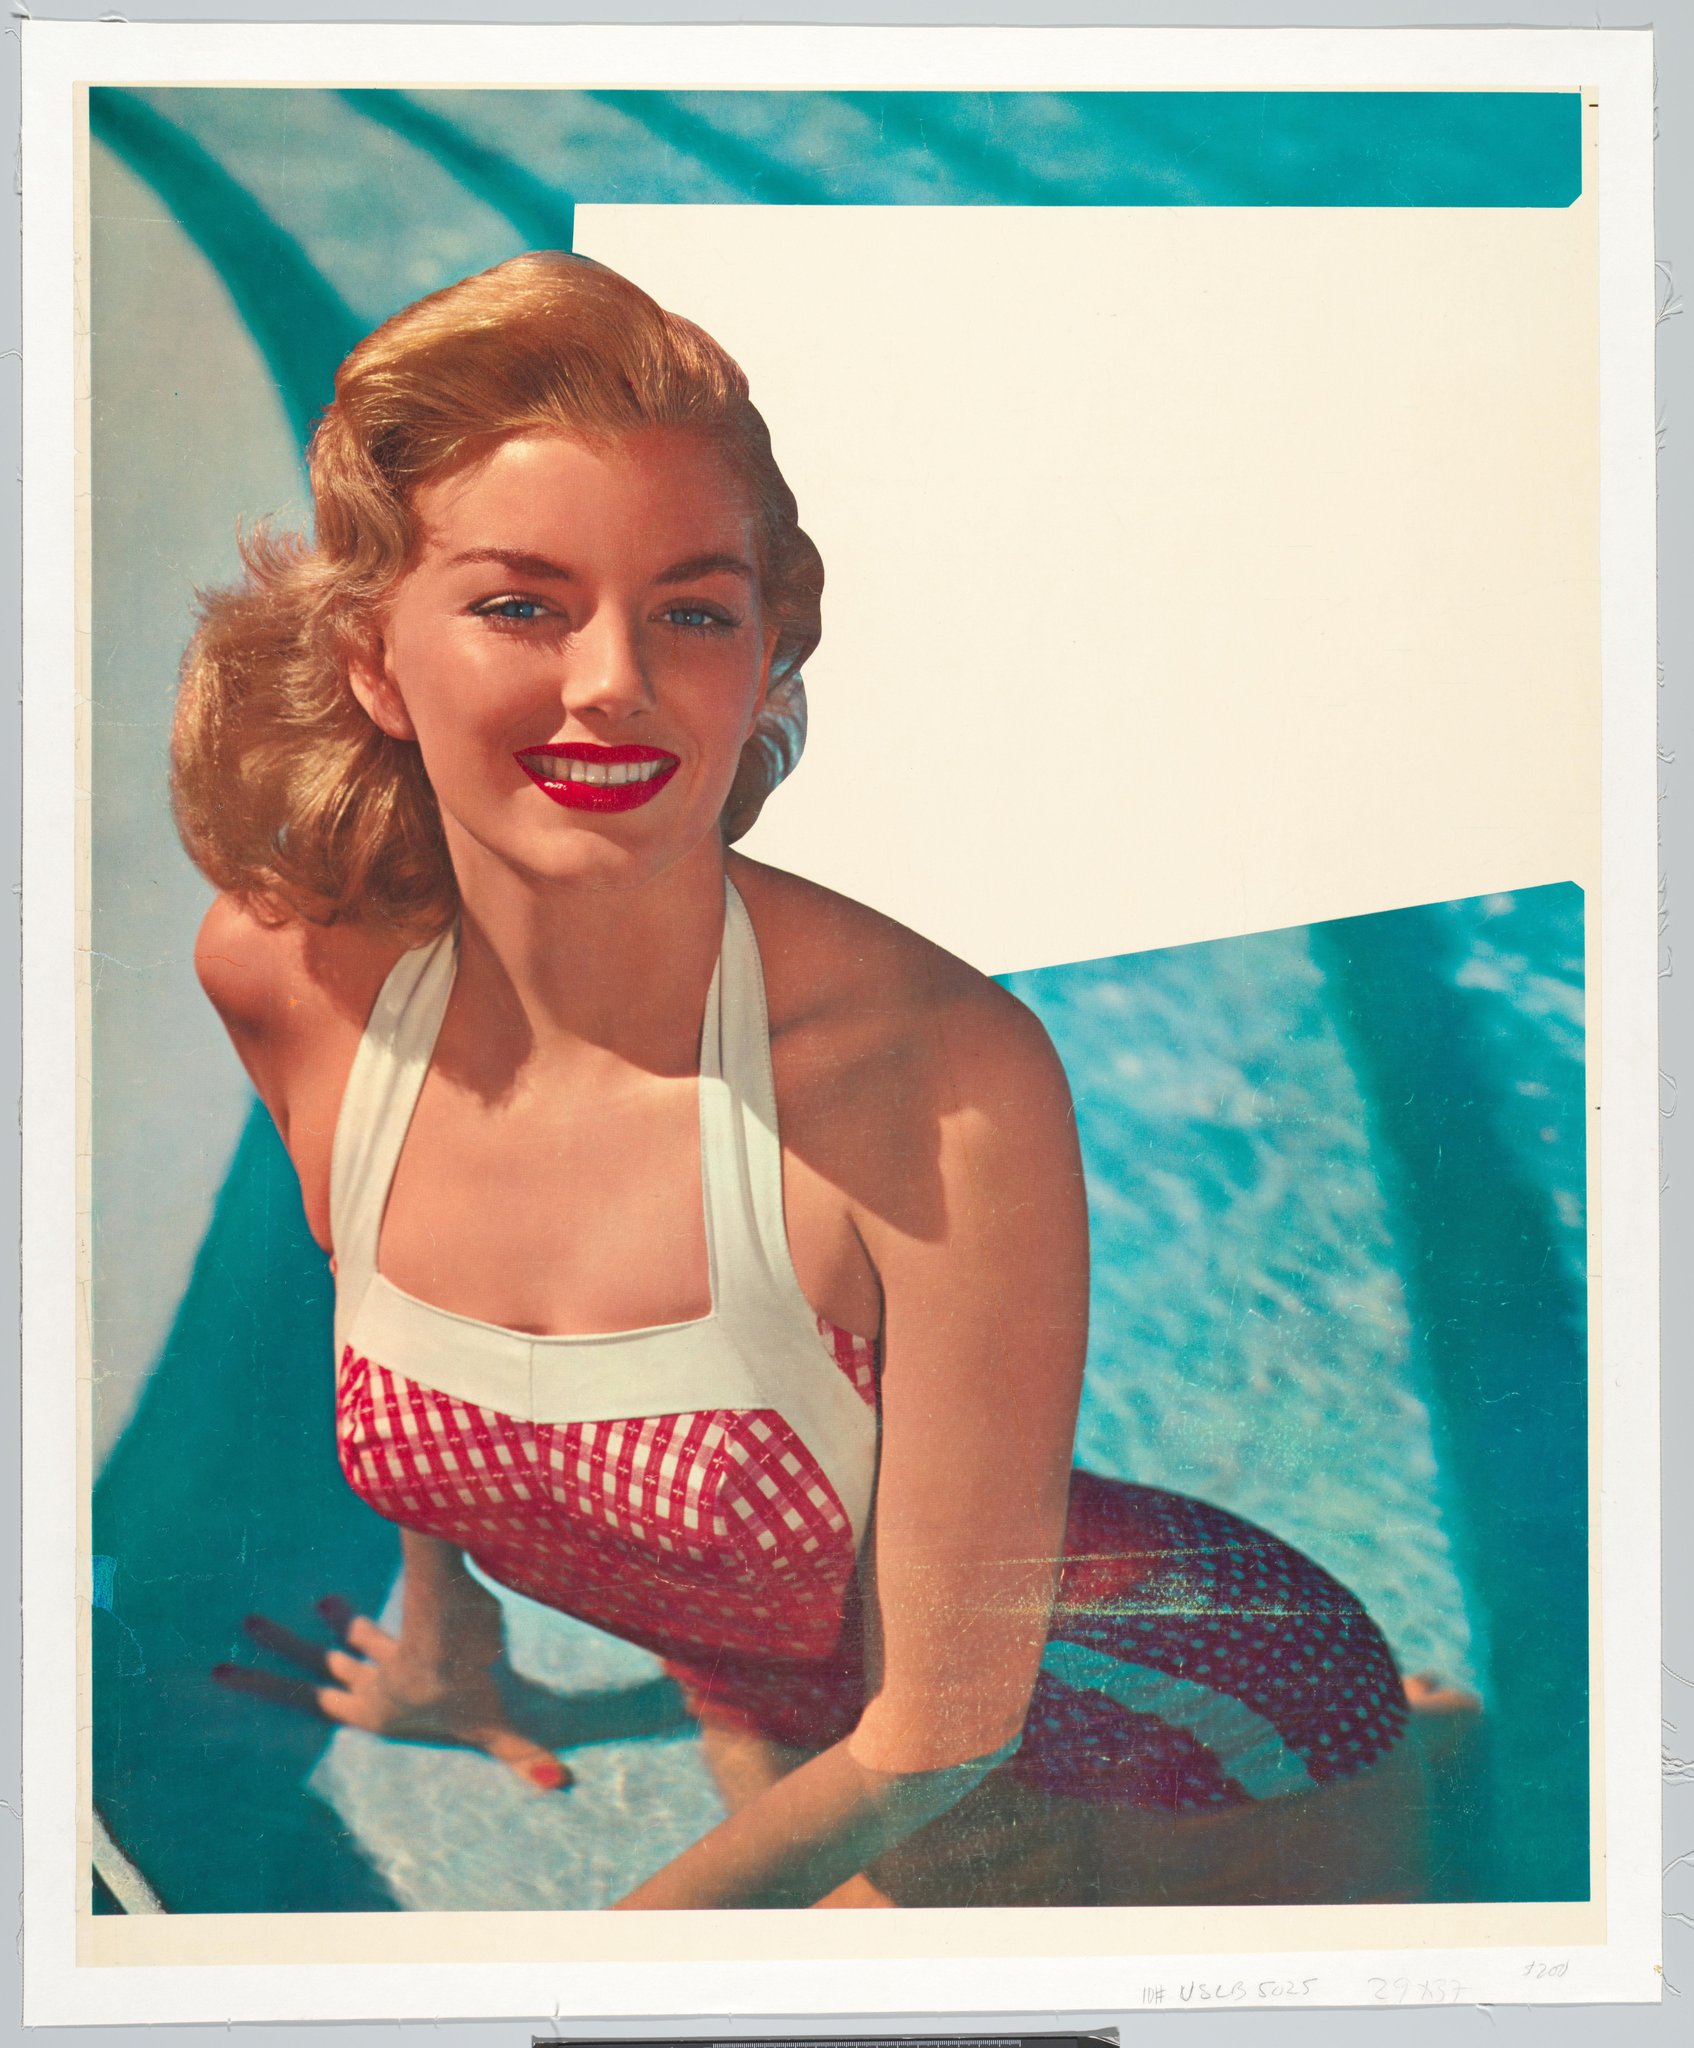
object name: poster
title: Vrouw in zwembad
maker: Anonymous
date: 1950-1960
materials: paper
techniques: offset printed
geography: united states